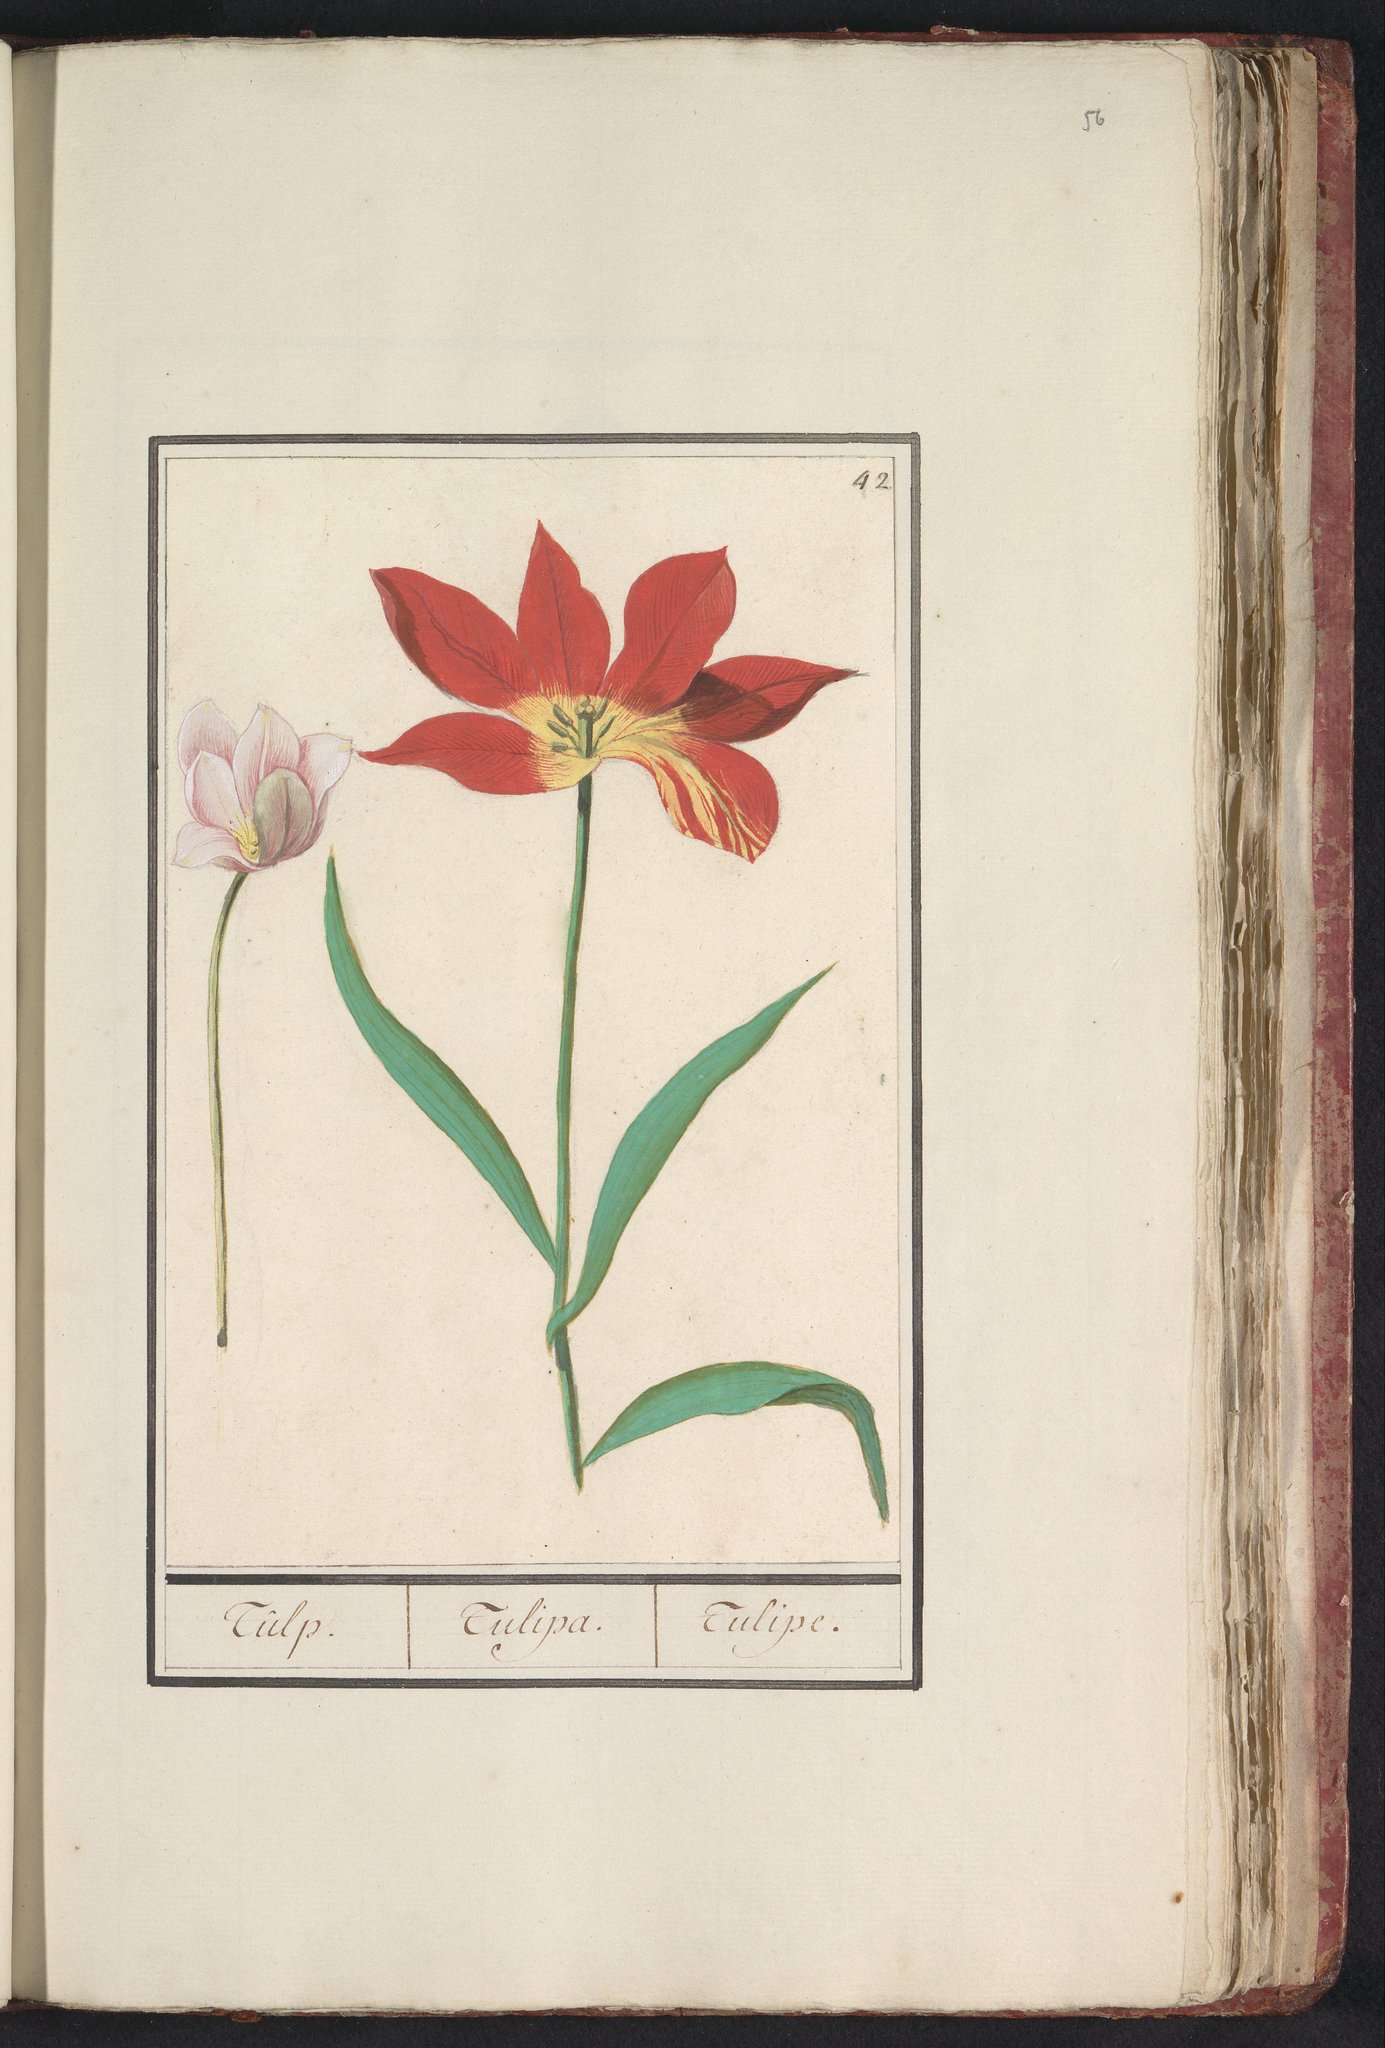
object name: drawing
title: Tulp (Tulipa)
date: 1596-1610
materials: chalk, paint, paper, watercolor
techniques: brush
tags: flowers: tulip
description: Wit-roze en rood-gele tulp. Genummerd rechtsboven: 42. Onderdeel van het eerste album met tekeningen van bloemen en planten. Achtste van twaalf albums met tekeningen van dieren, vogels en planten bekend rond 1600, gemaakt in opdracht van keizer Rudolf II. Met toelichting in Nederlands, Latijn en Frans.